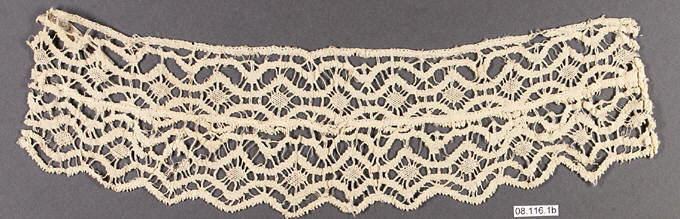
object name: fragment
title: Fragment of lace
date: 1701-1800